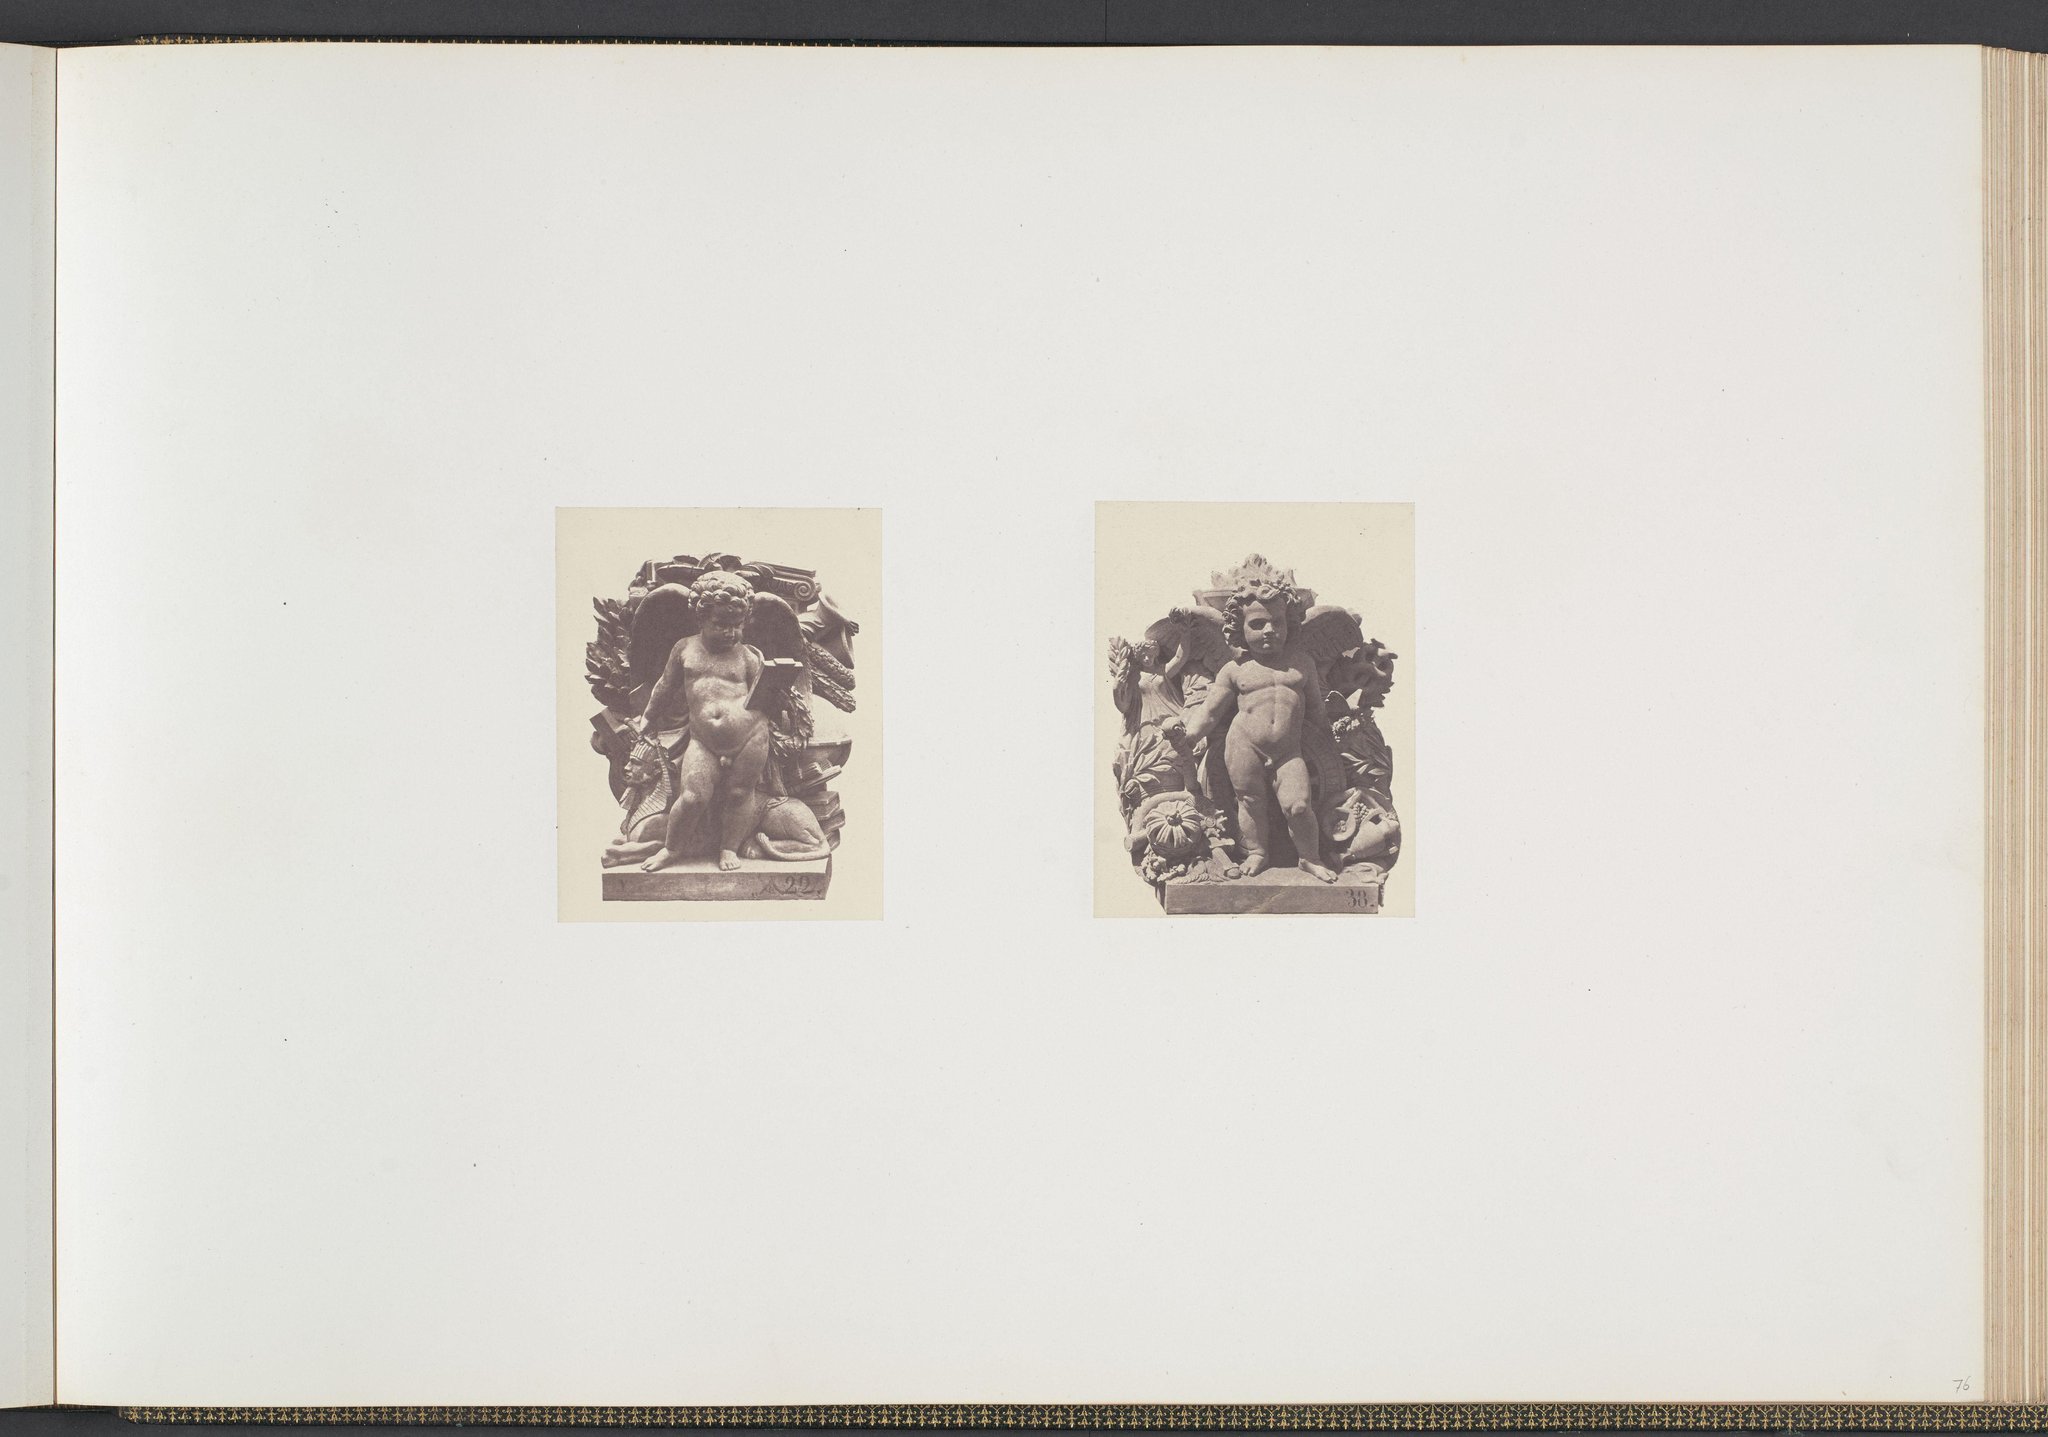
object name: photograph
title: Gipsmodellen voor beeldhouwwerken op het Palais du Louvre: links "L'Etude" door Joseph Alexandre Renoir en rechts "La Fortune" door Etienne Montagny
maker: édouard denis baldus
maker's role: fotograaf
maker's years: 1813-1889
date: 1855-1857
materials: paper, photographic support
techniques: salted paper print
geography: paris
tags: piece of sculpture, reproduction of a piece of sculpture, permanent exhibition, museum, paris, tuileries palace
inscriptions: number: ‘22 en 38’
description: Onderdeel van Réunion des Tuileries au Louvre 1852-1857, album 2.